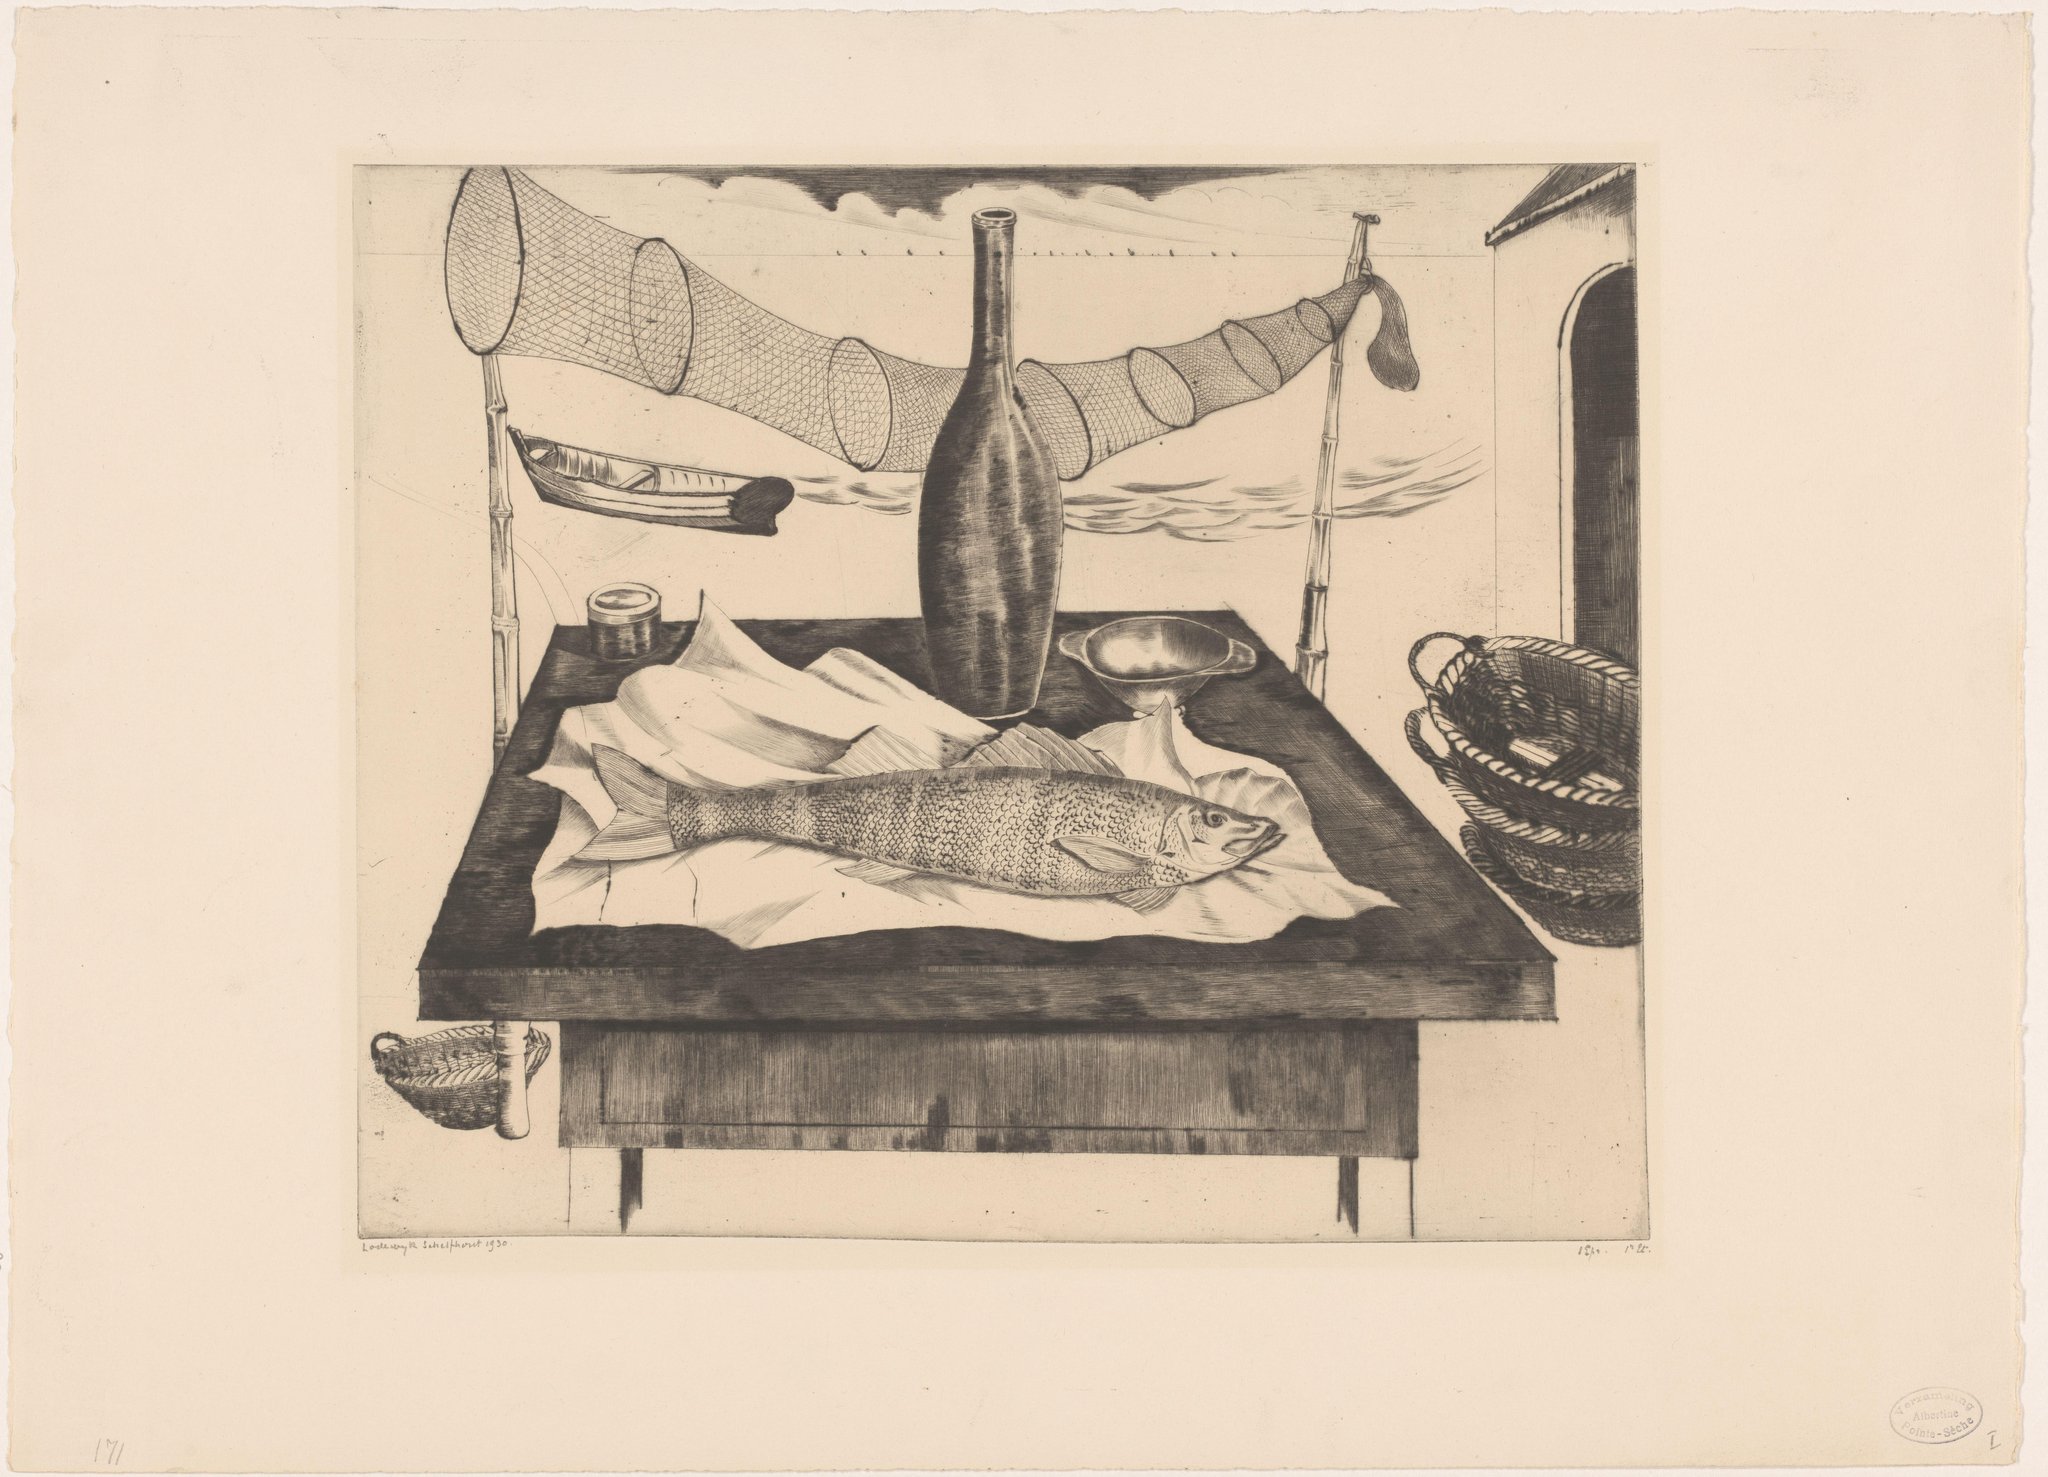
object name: print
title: Après la pêche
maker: lodewijk schelfhout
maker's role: draughtsman, print maker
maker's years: 1881-1943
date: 1930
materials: paper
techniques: drypoint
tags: fishing net, fishes, still life of miscellaneous objects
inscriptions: collector's mark: Lugt 5i, collector's mark: Lugt 2228, collector's mark: Lugt 2760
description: Een vis ligt op een tafel waar ook een fles en een kom op staan. Op de achtergrond hangt een visnet aan twee palen en bevindt er zich een boot in het water. Links en rechts vier rieten manden.